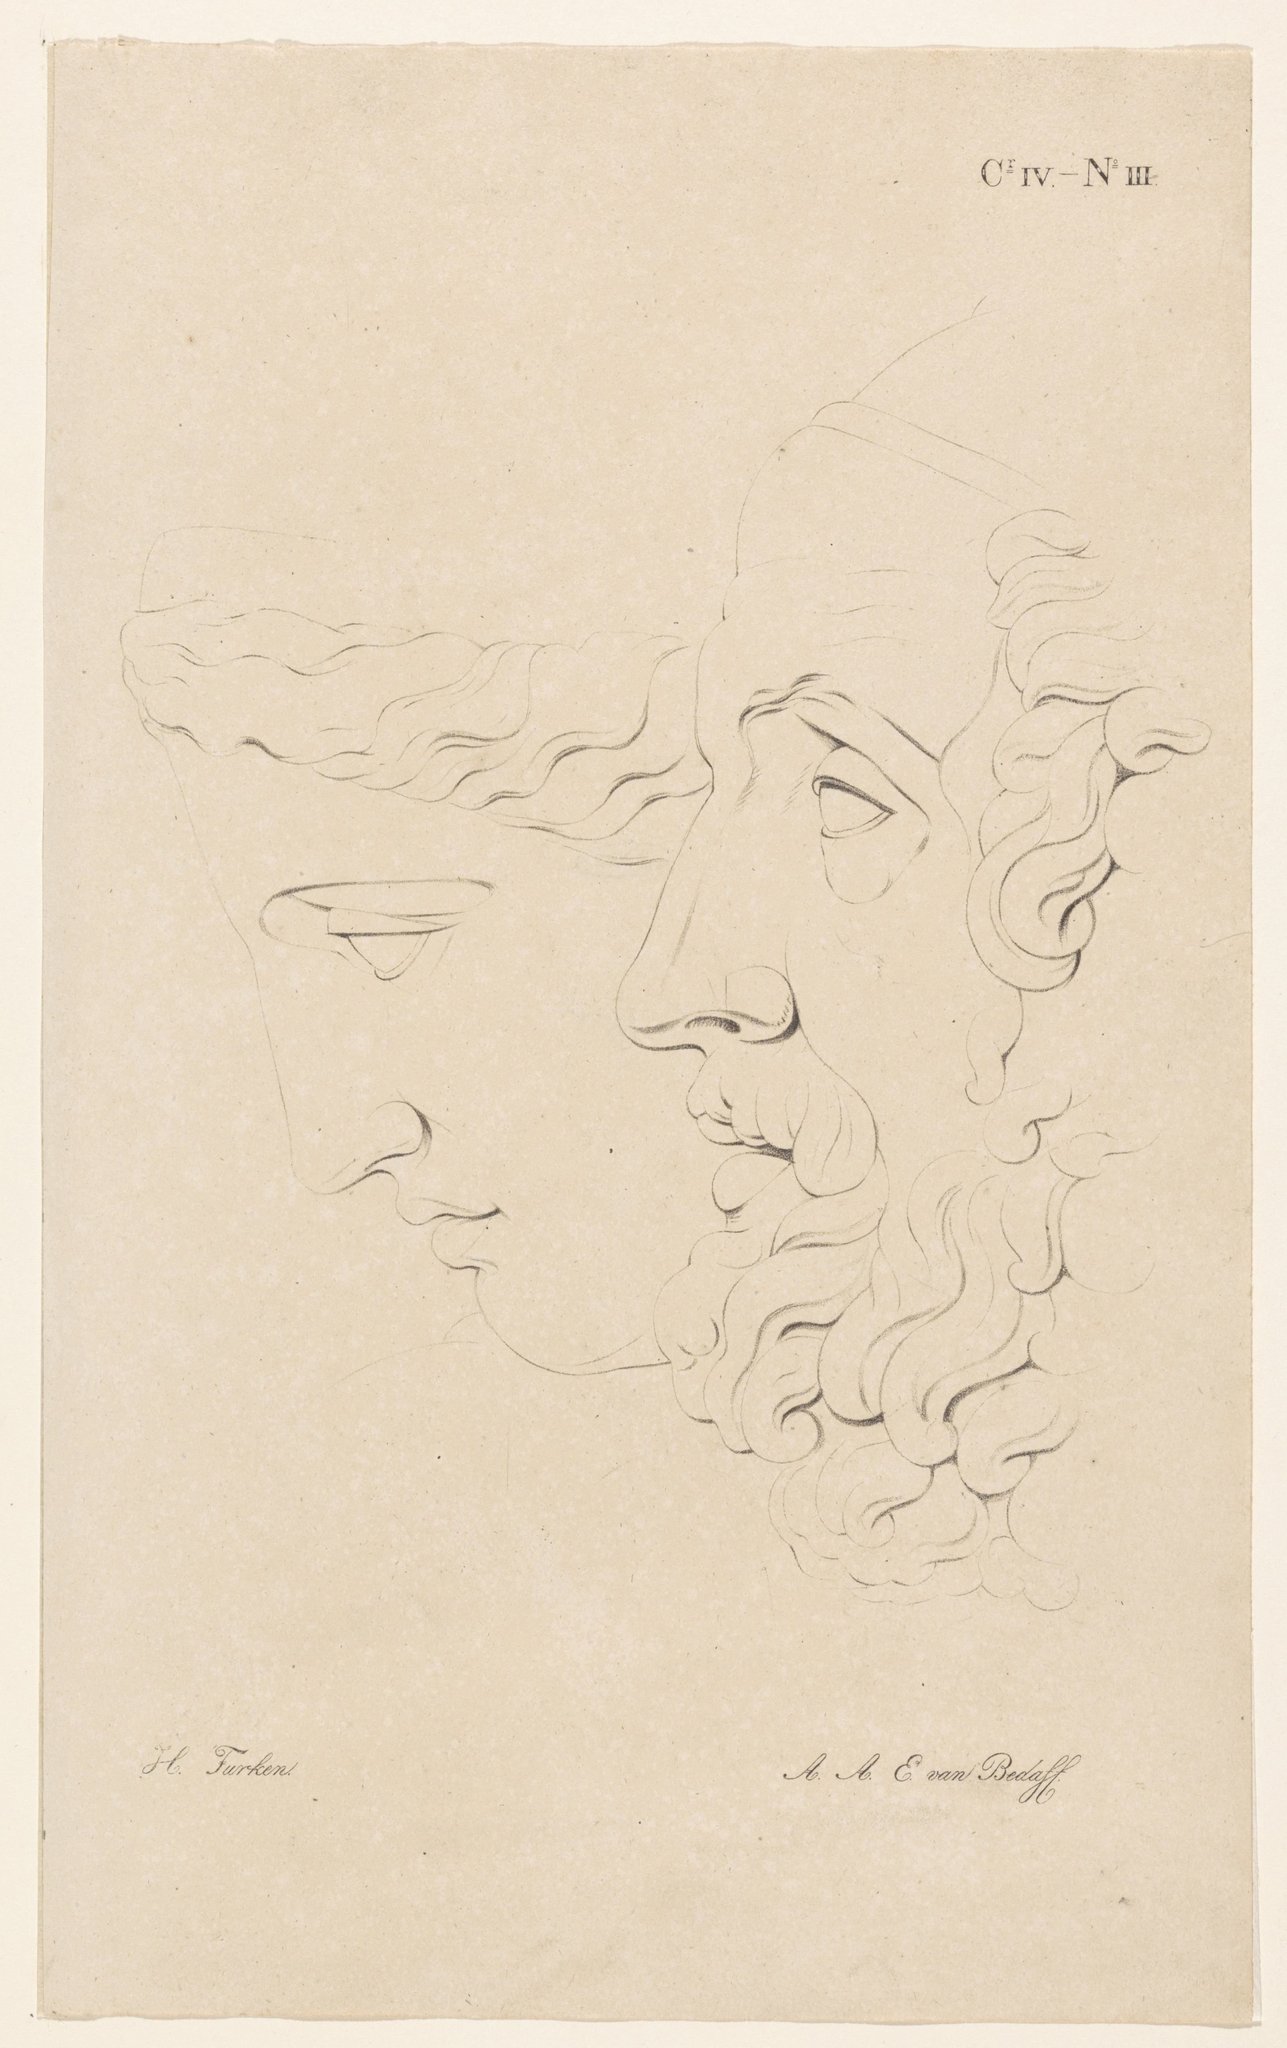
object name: print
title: Studies naar twee antieke koppen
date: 1822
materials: paper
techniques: lithograph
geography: den bosch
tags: head (human) (+ sideview, profile), male persons from classical history, female persons from classical history, human figure of ideal proportions, e.g. academic nude - aa - female human figure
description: Dit blad maakte deel uit van: Grondbeginselen der Teekenkunst in Fragmenten naar de Antieken. Het werd gedrukt in Den Bosch bij J.F. Demelinne in 1822. Het waren zes cahiers van ieder vijf bladen. Bron: Moulijn, 1927: 71.